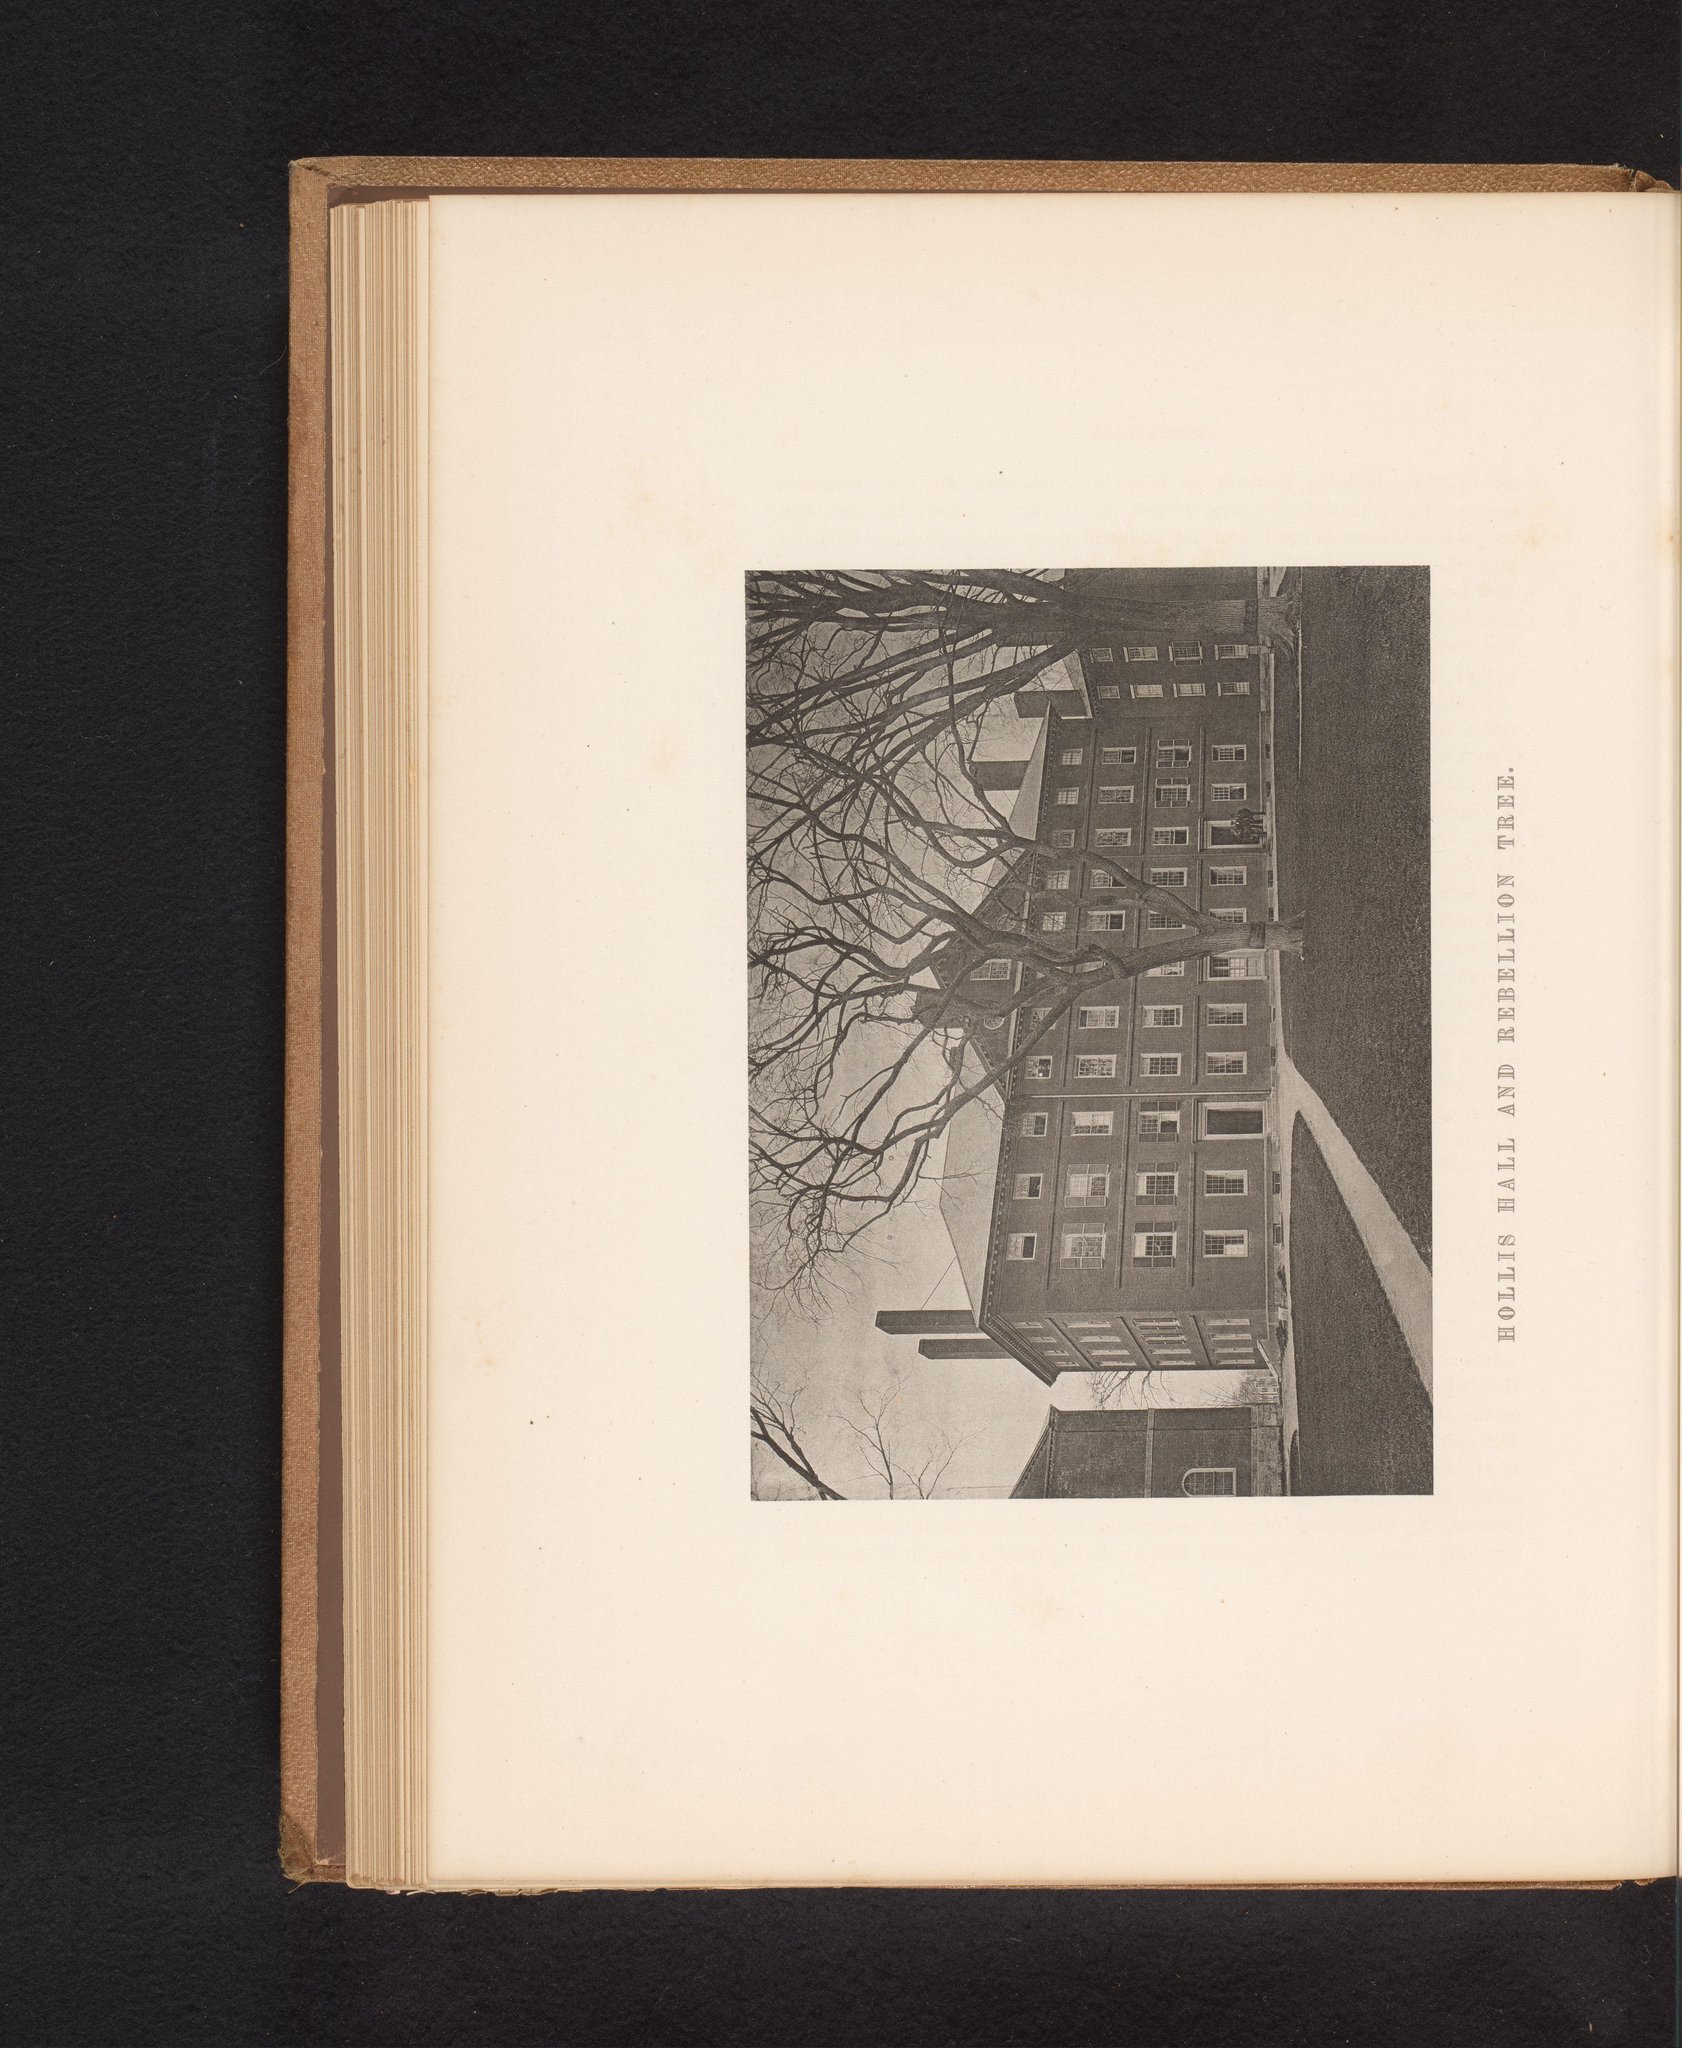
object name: page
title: Gezicht op de Hollis Hall van de Harvard-universiteit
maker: Anonymous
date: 1870-1875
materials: paper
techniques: photograph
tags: housing, university building, college